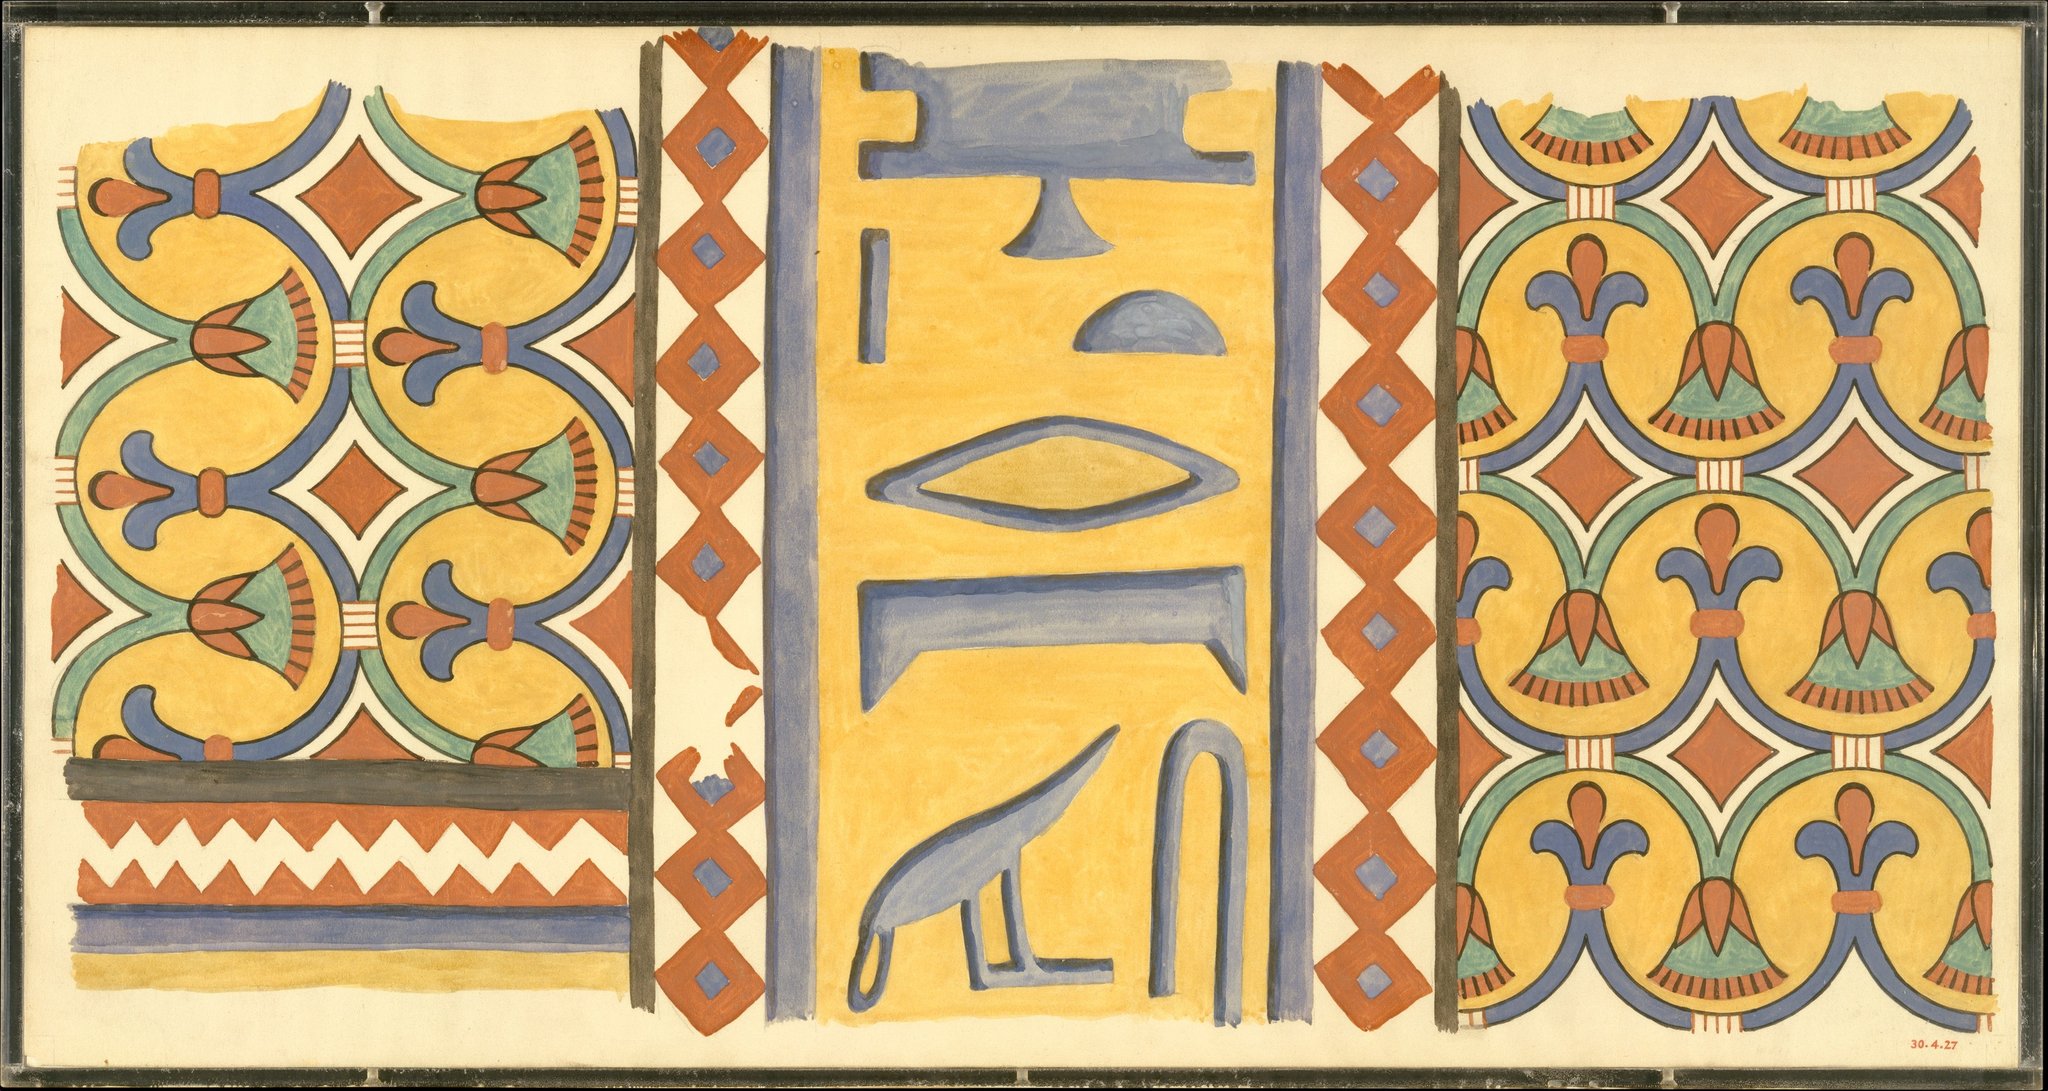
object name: facsimile, amenemhat surer tt 48, ceiling enhanced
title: Ceiling Fragment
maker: hugh r. hopgood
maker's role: artist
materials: paper, paint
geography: egypt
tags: hieroglyphs